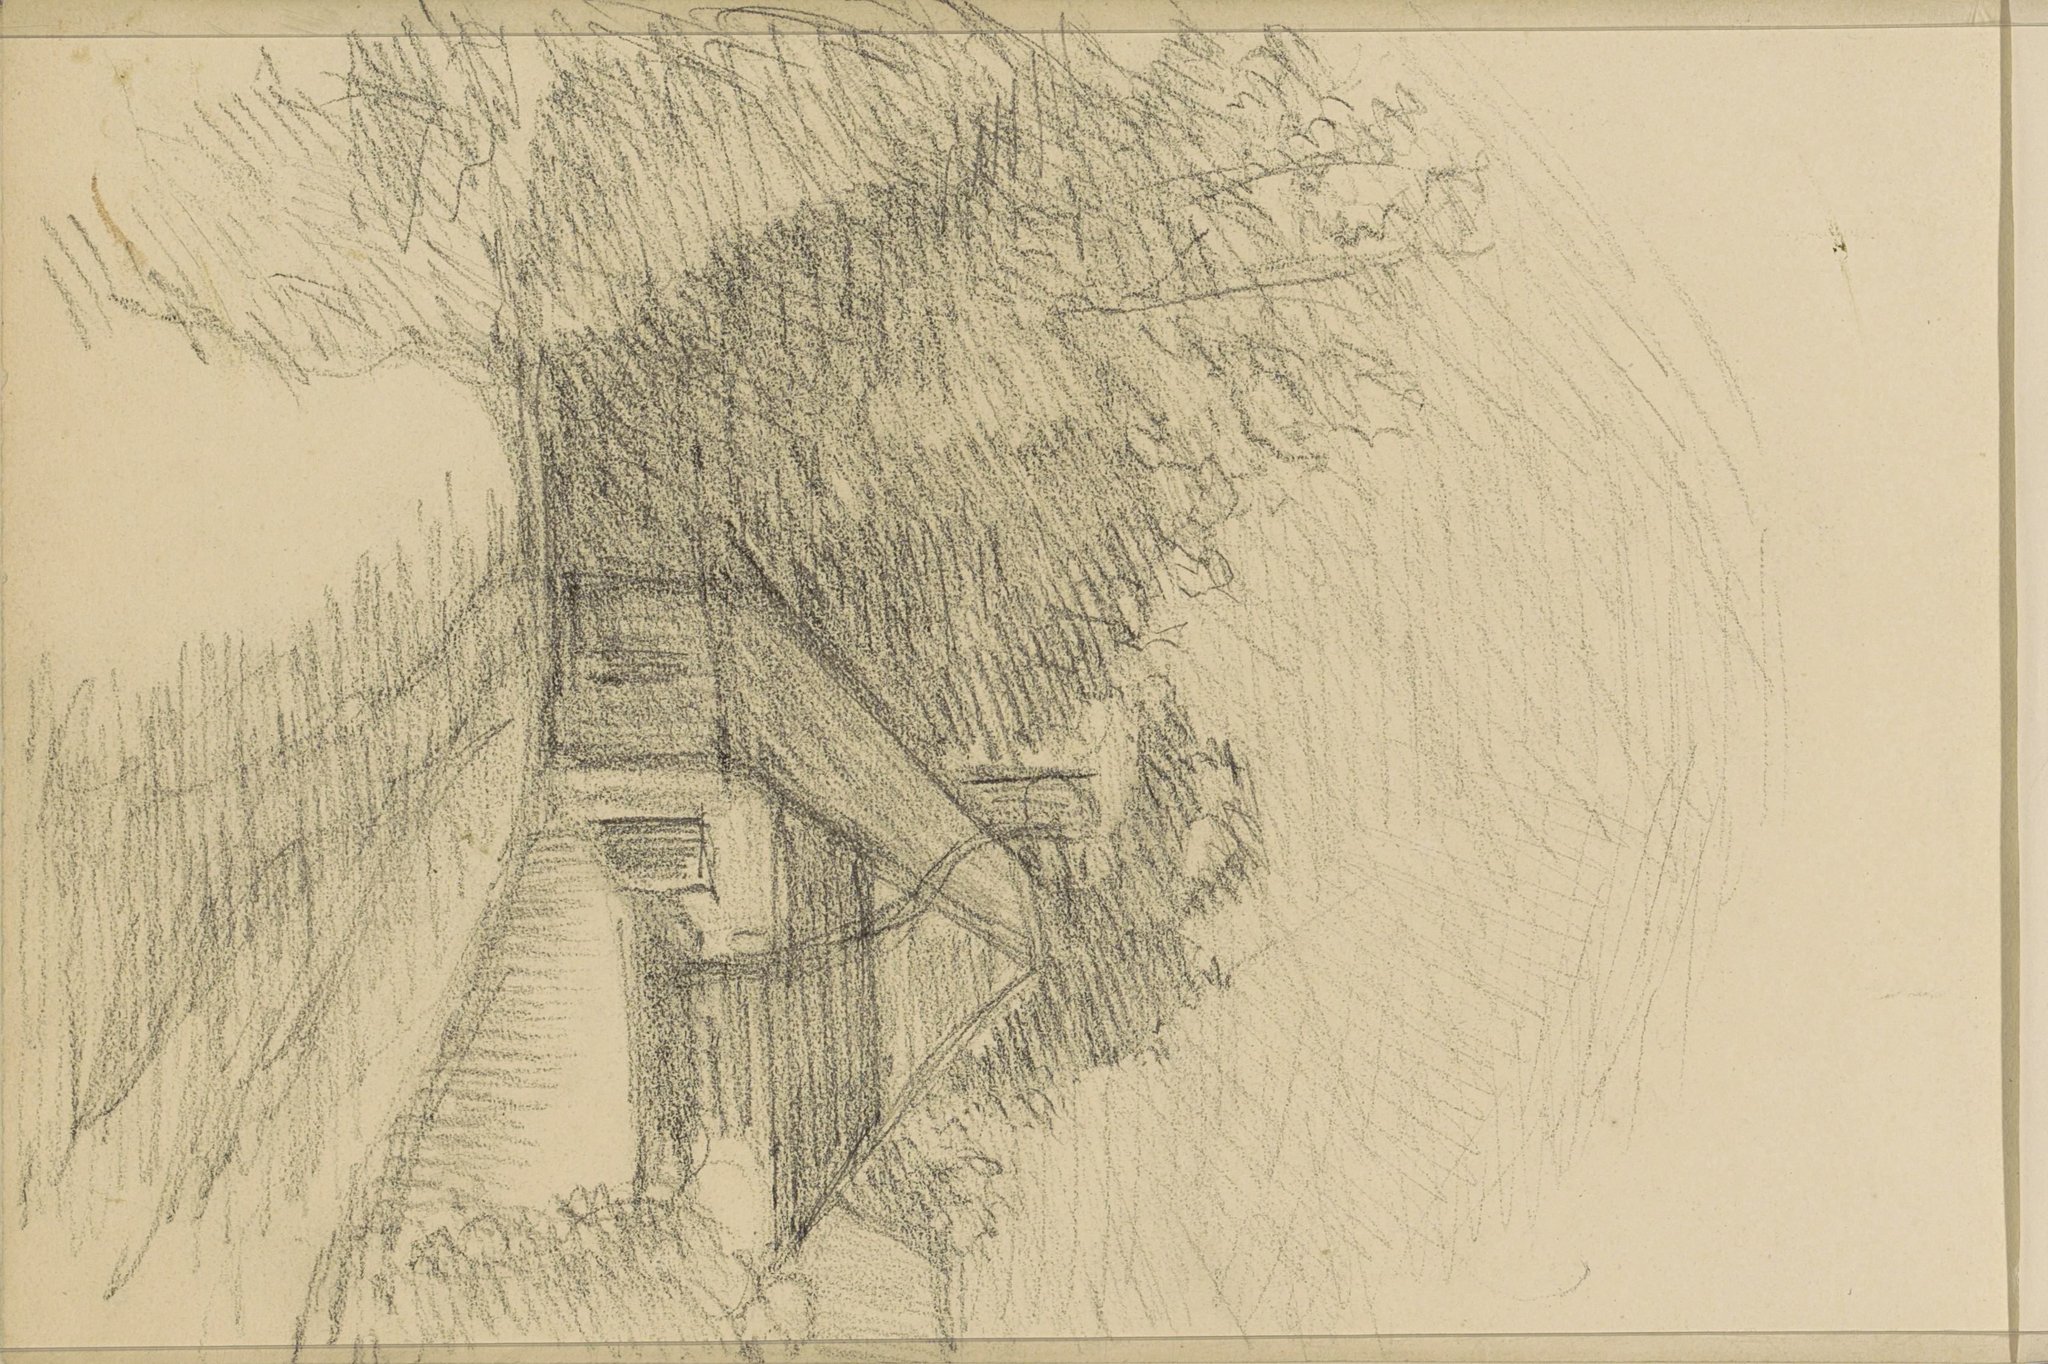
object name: sketchbook leaf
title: Plattelandswoning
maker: jozef israëls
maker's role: draughtsman, painter, print maker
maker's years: 1824-1911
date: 1834-1911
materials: chalk, paper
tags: farm or solitary house in landscape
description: Blad 24 verso uit een schetsboek met 25 bladen.